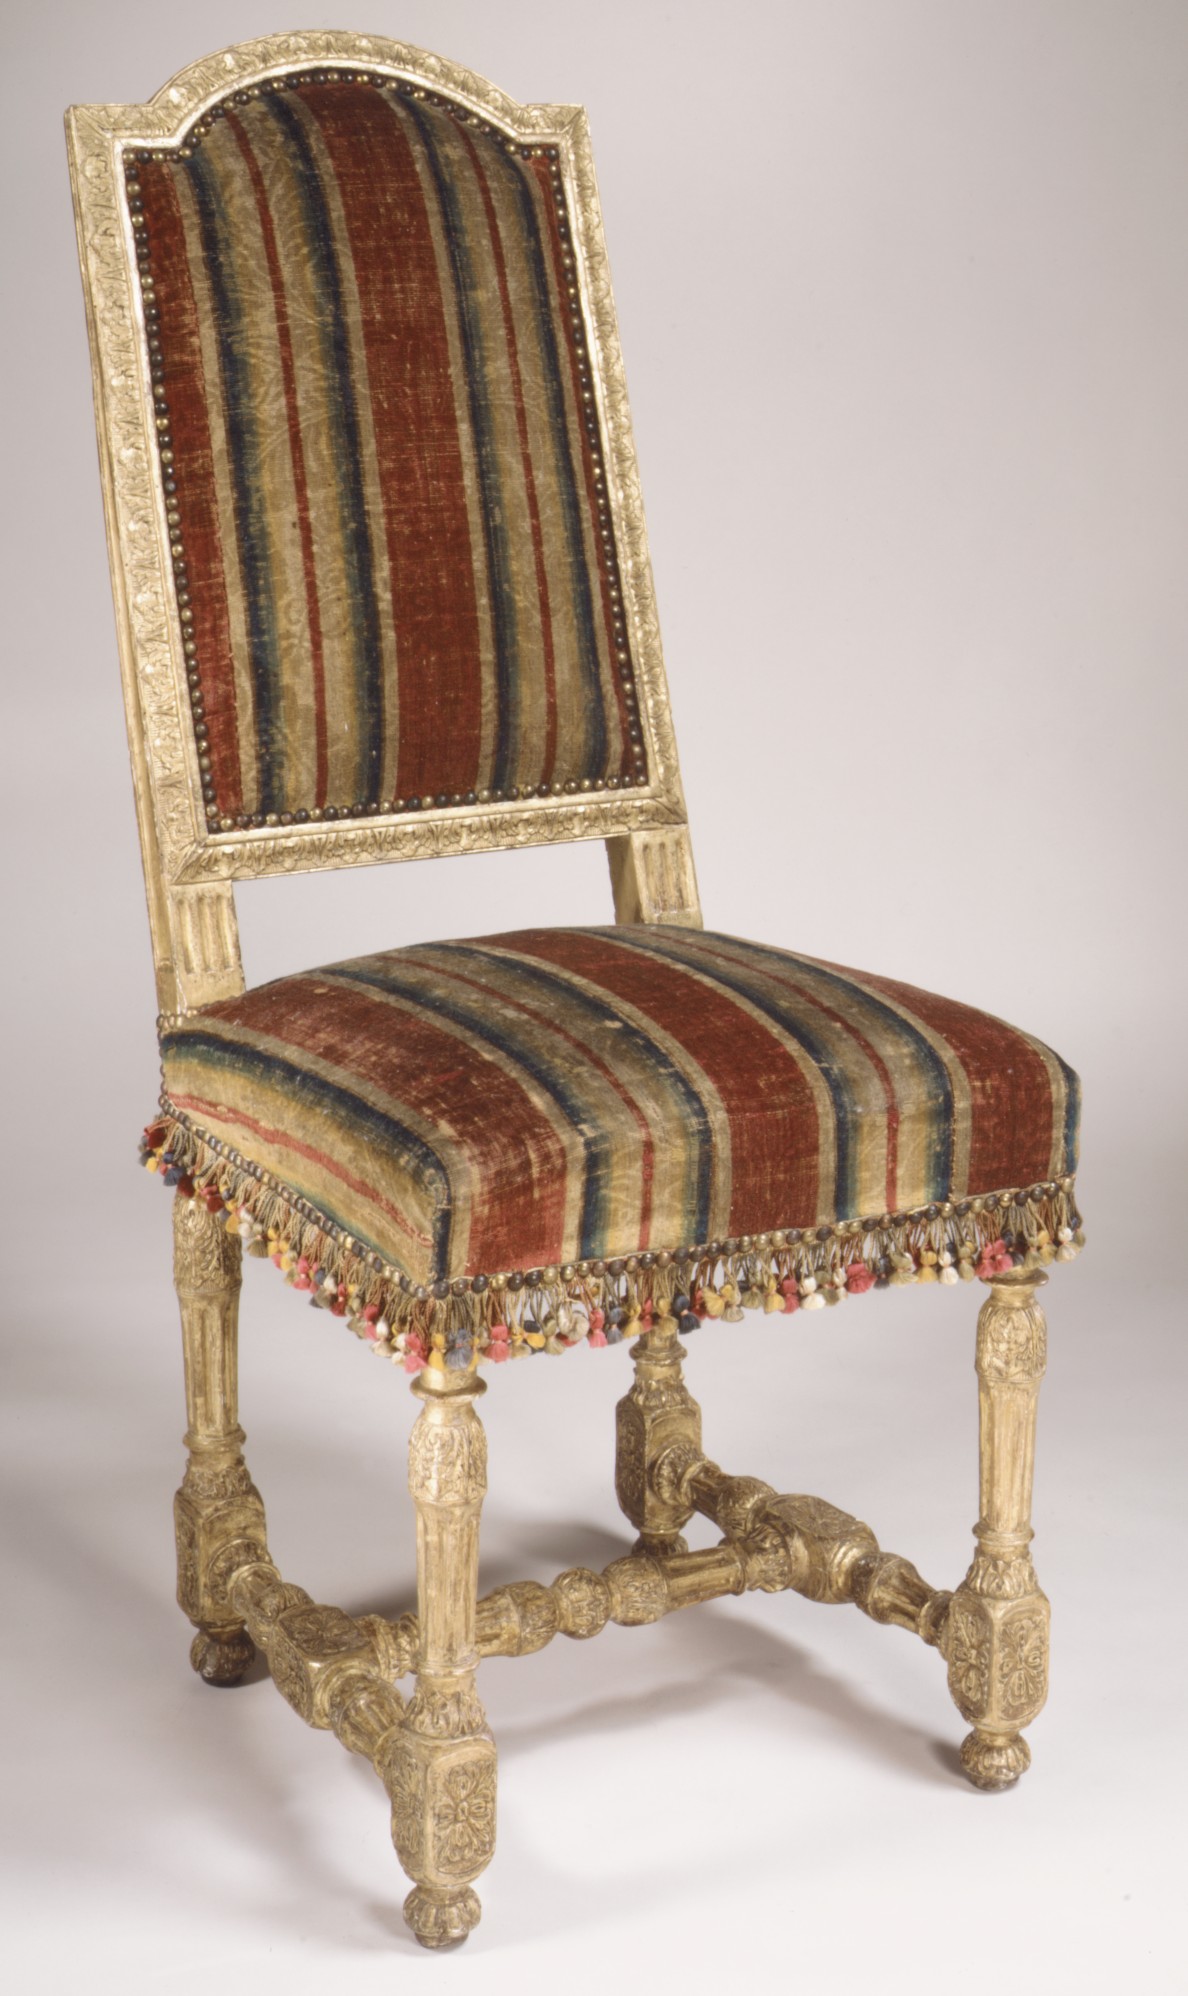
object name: side chair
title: Side chair (one of a pair)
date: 1690-1700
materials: wood, velvet, wool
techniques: carving, gilding